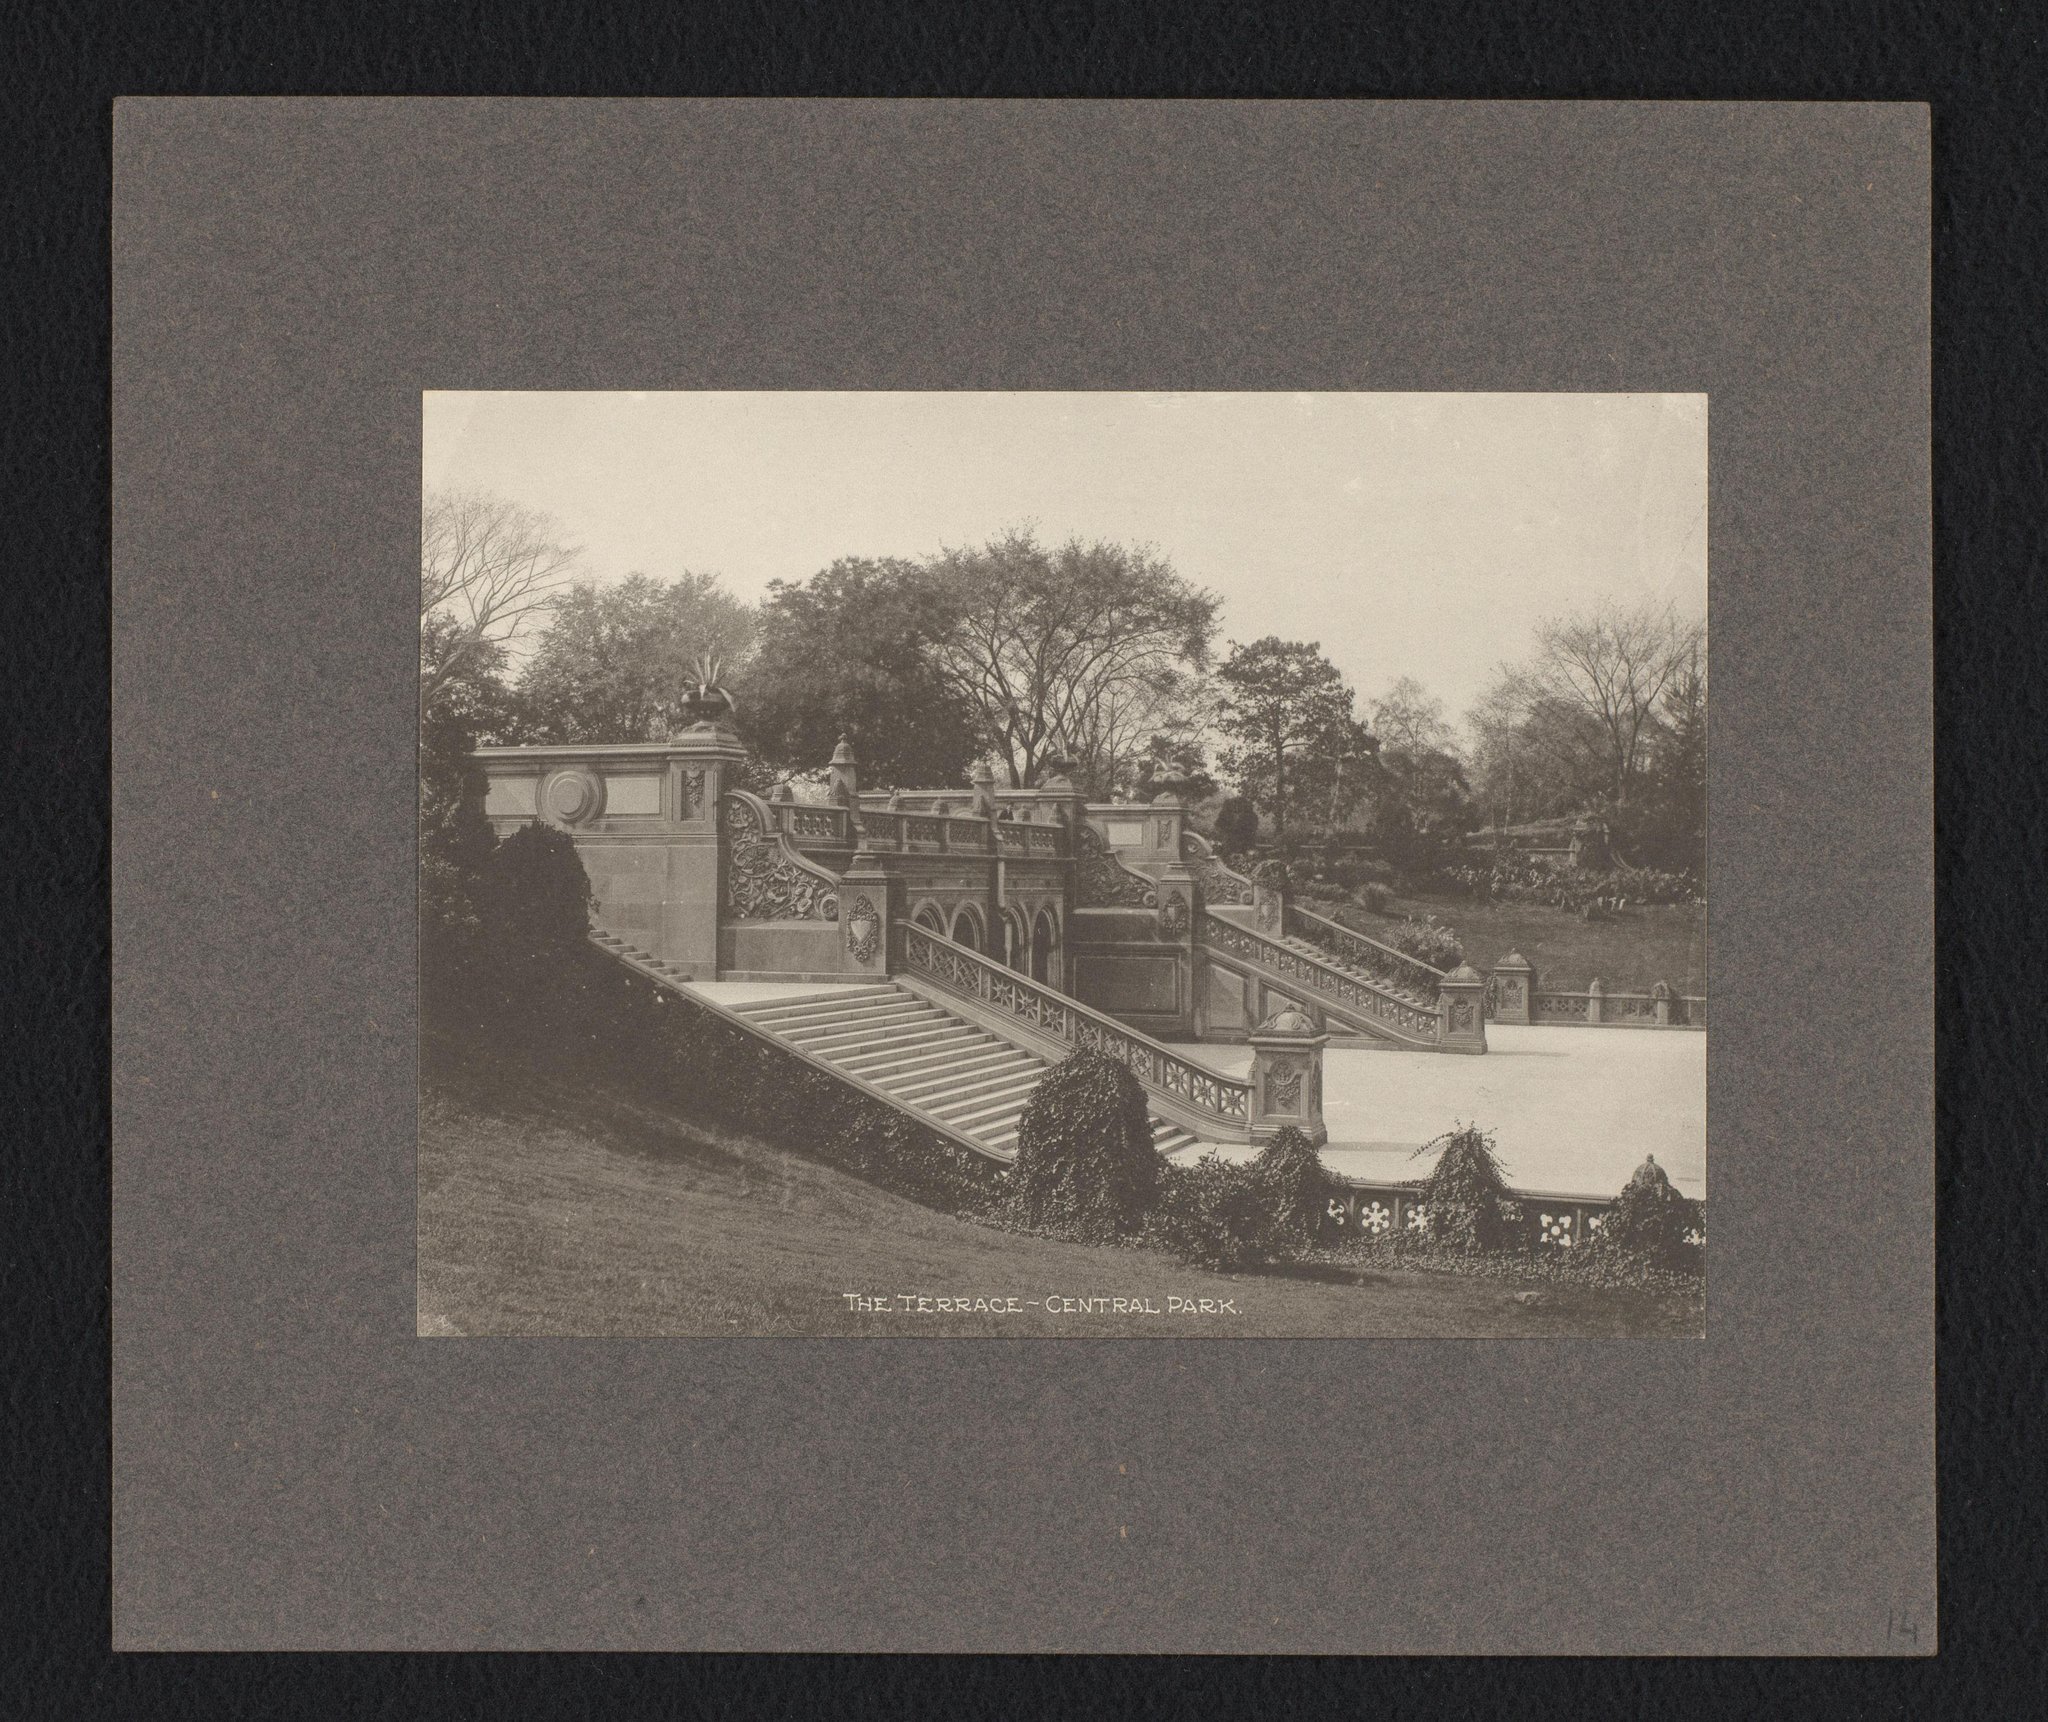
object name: photomechanical print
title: The Terrace - Central Park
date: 1902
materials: paper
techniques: photograph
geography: new york city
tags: public gardens, park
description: Deze prent maakt deel uit van een album.